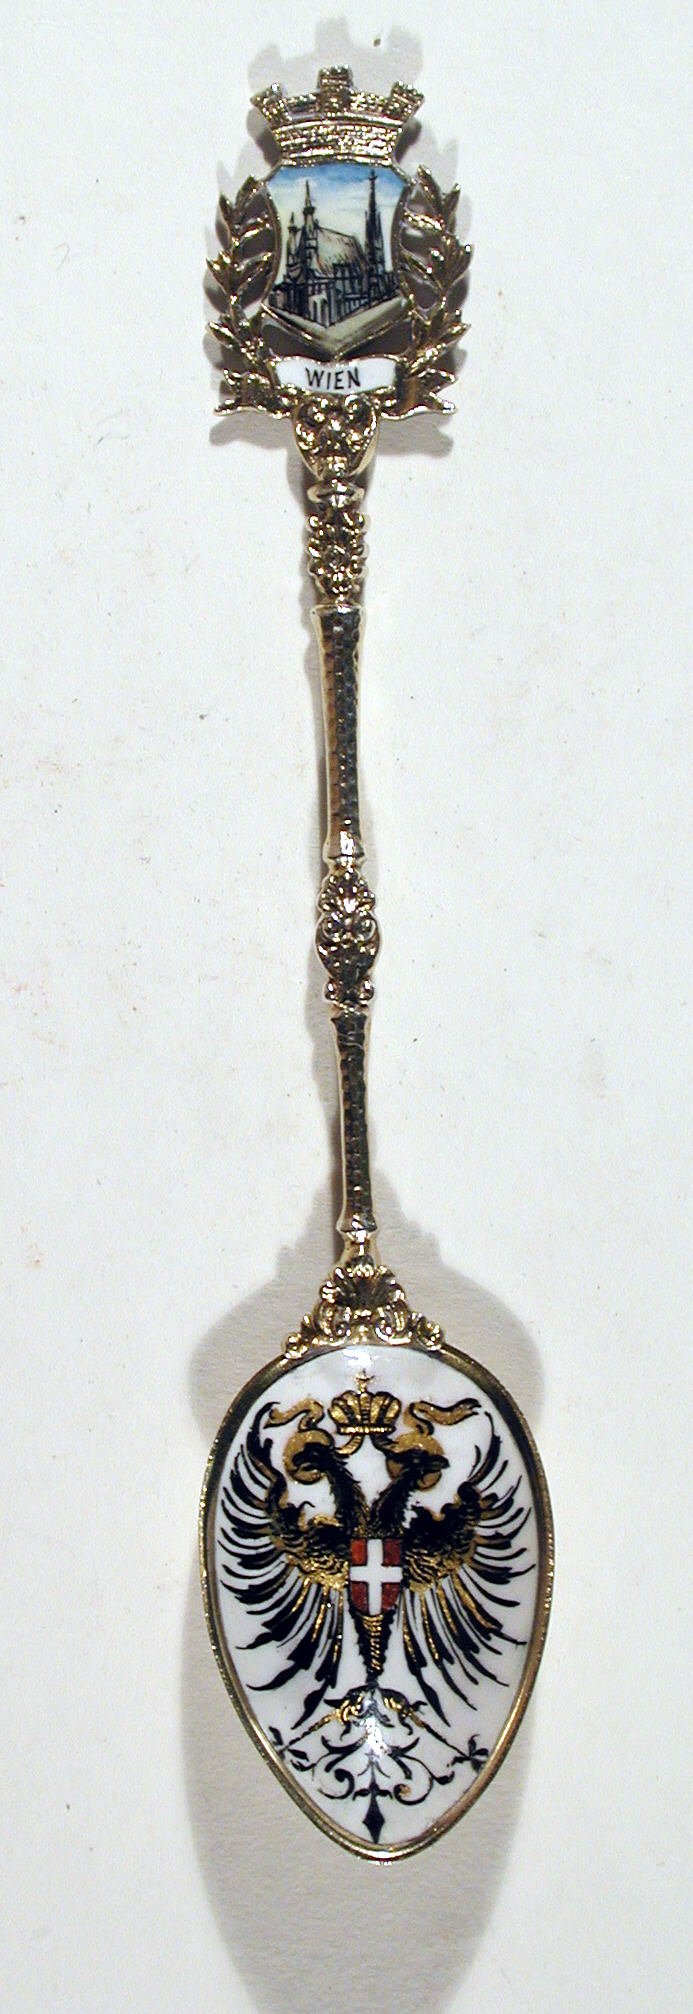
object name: souvenir spoon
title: Souvenir spoon with Imperial double-headed eagle and St. Stephan's Cathedral in Vienna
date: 1867-1900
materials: enamel, silver gilt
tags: churches,coat of arms